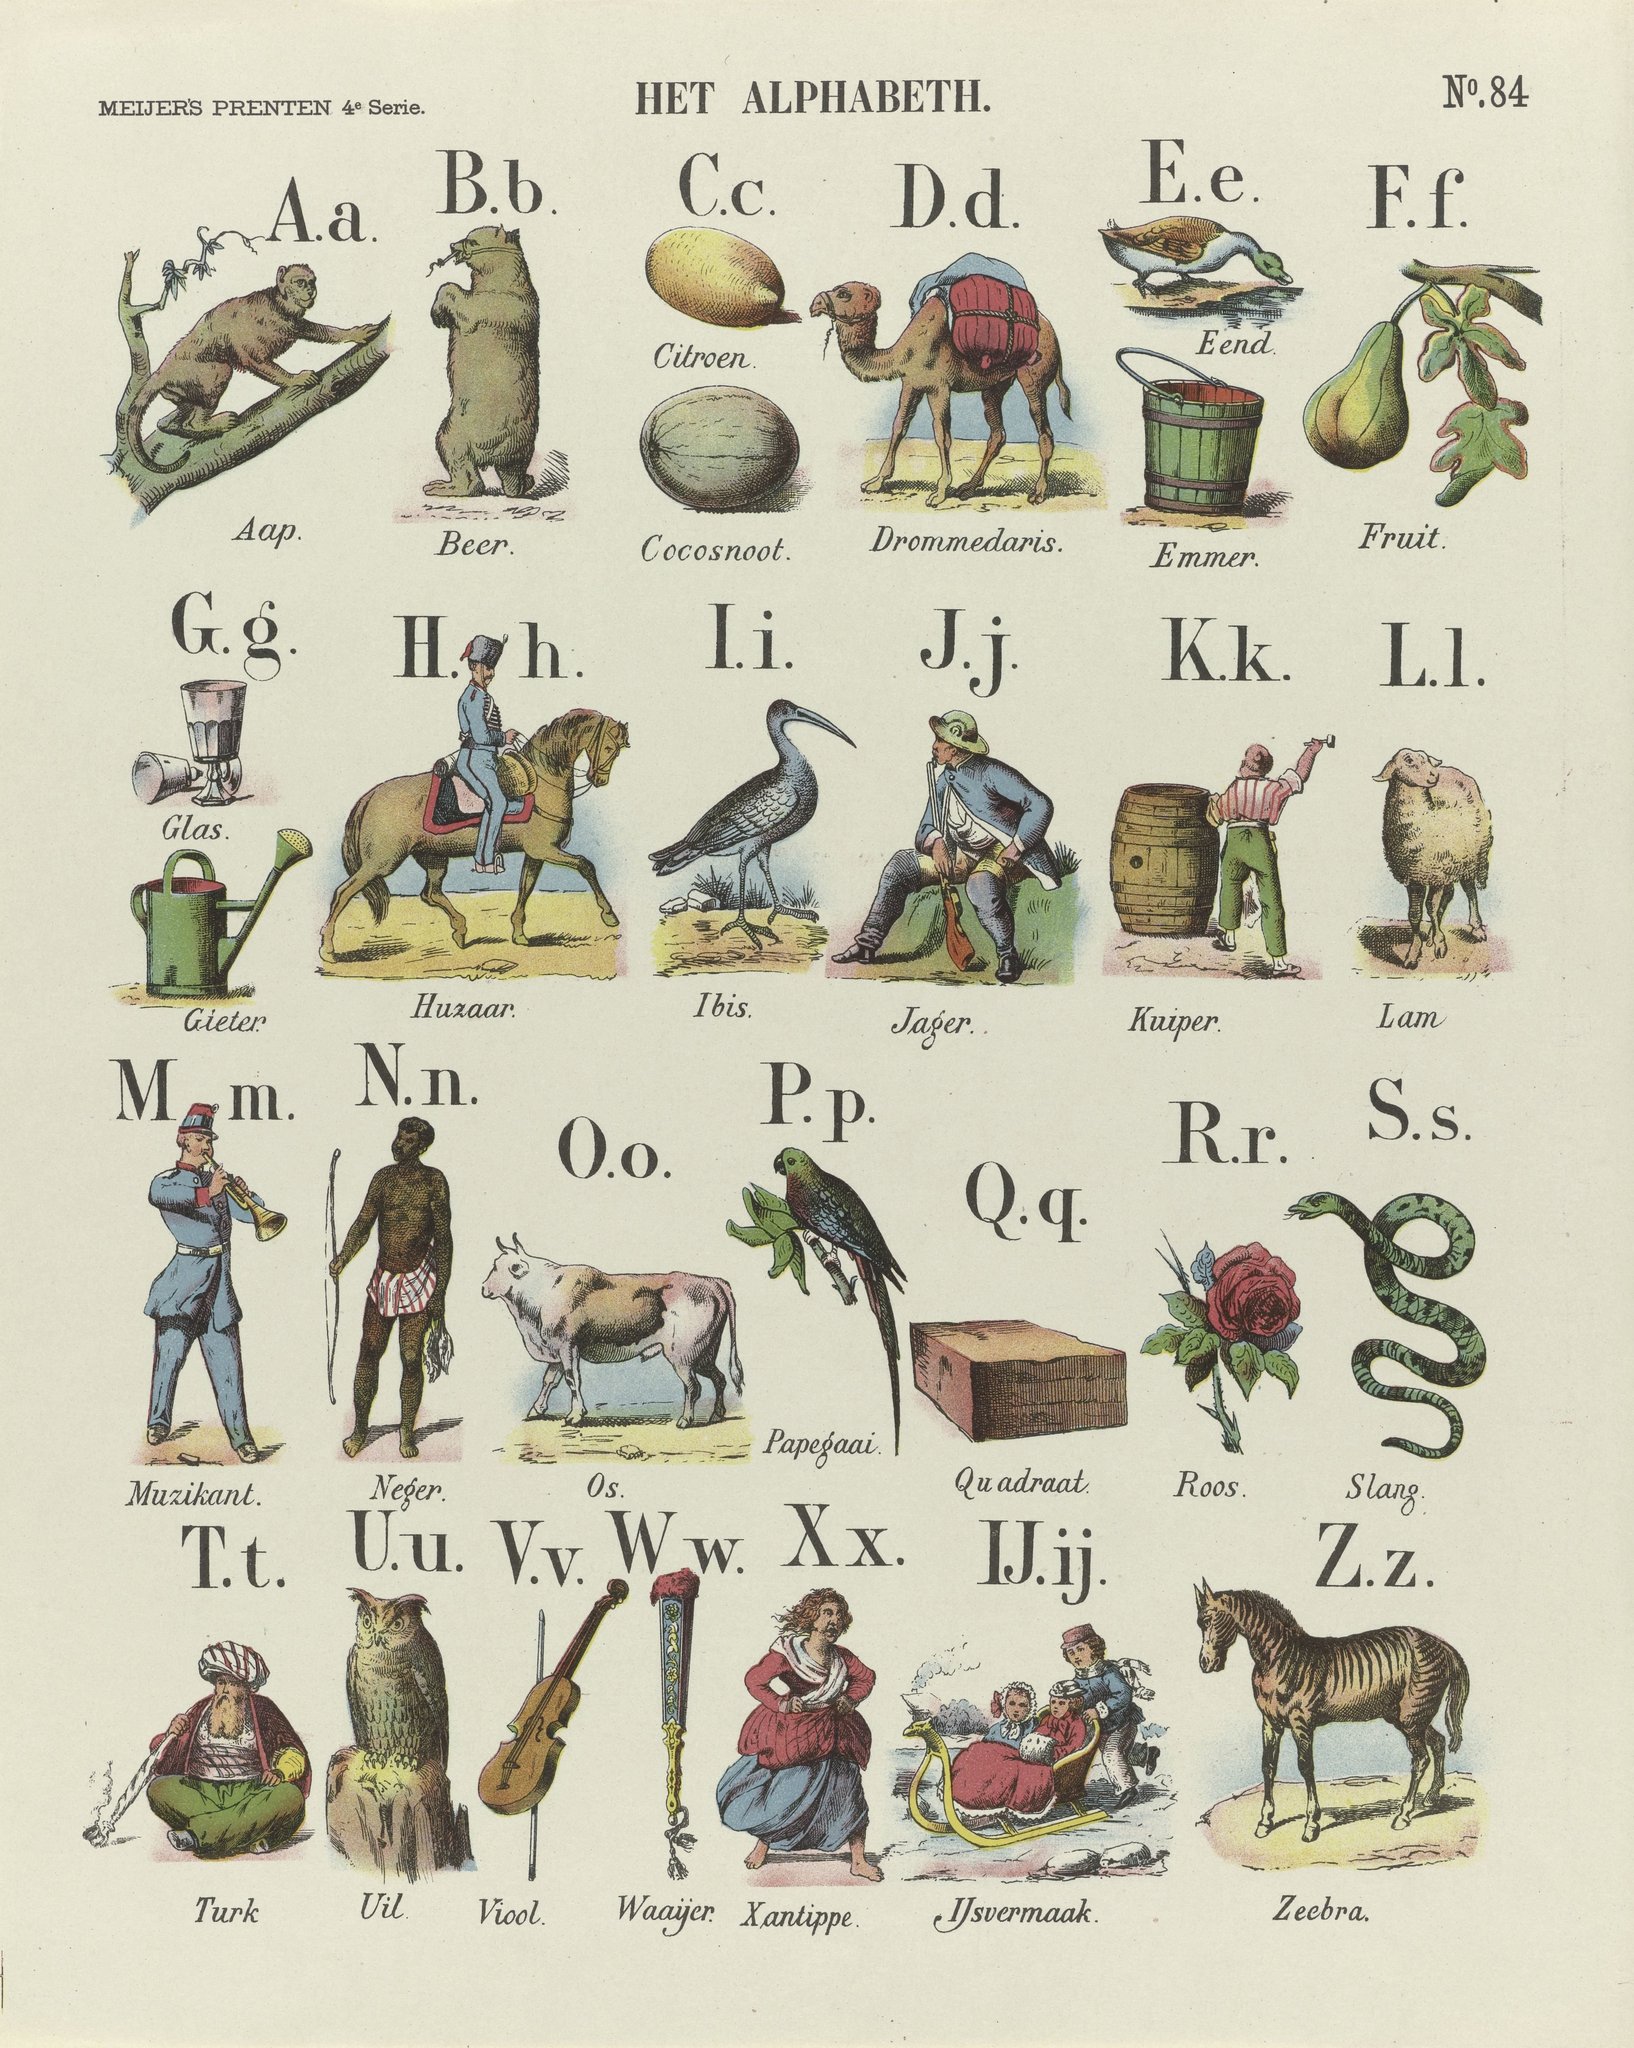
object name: print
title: Meijer's prenten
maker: Anonymous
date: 1881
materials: paper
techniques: lithograph, letterpress printing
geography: amsterdam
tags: animals, letters, alphabet, script, characters (human types), fruits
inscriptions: collector's mark: Lugt 2760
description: Blad met 29 voorstellingen van de letters van het alfabet geïllustreerd met voorwerpen, dieren en figuren waarvan de woorden met de betreffende letter beginnen. Onder elke afbeelding een onderschrift. Genummerd rechtsboven: No. 84.